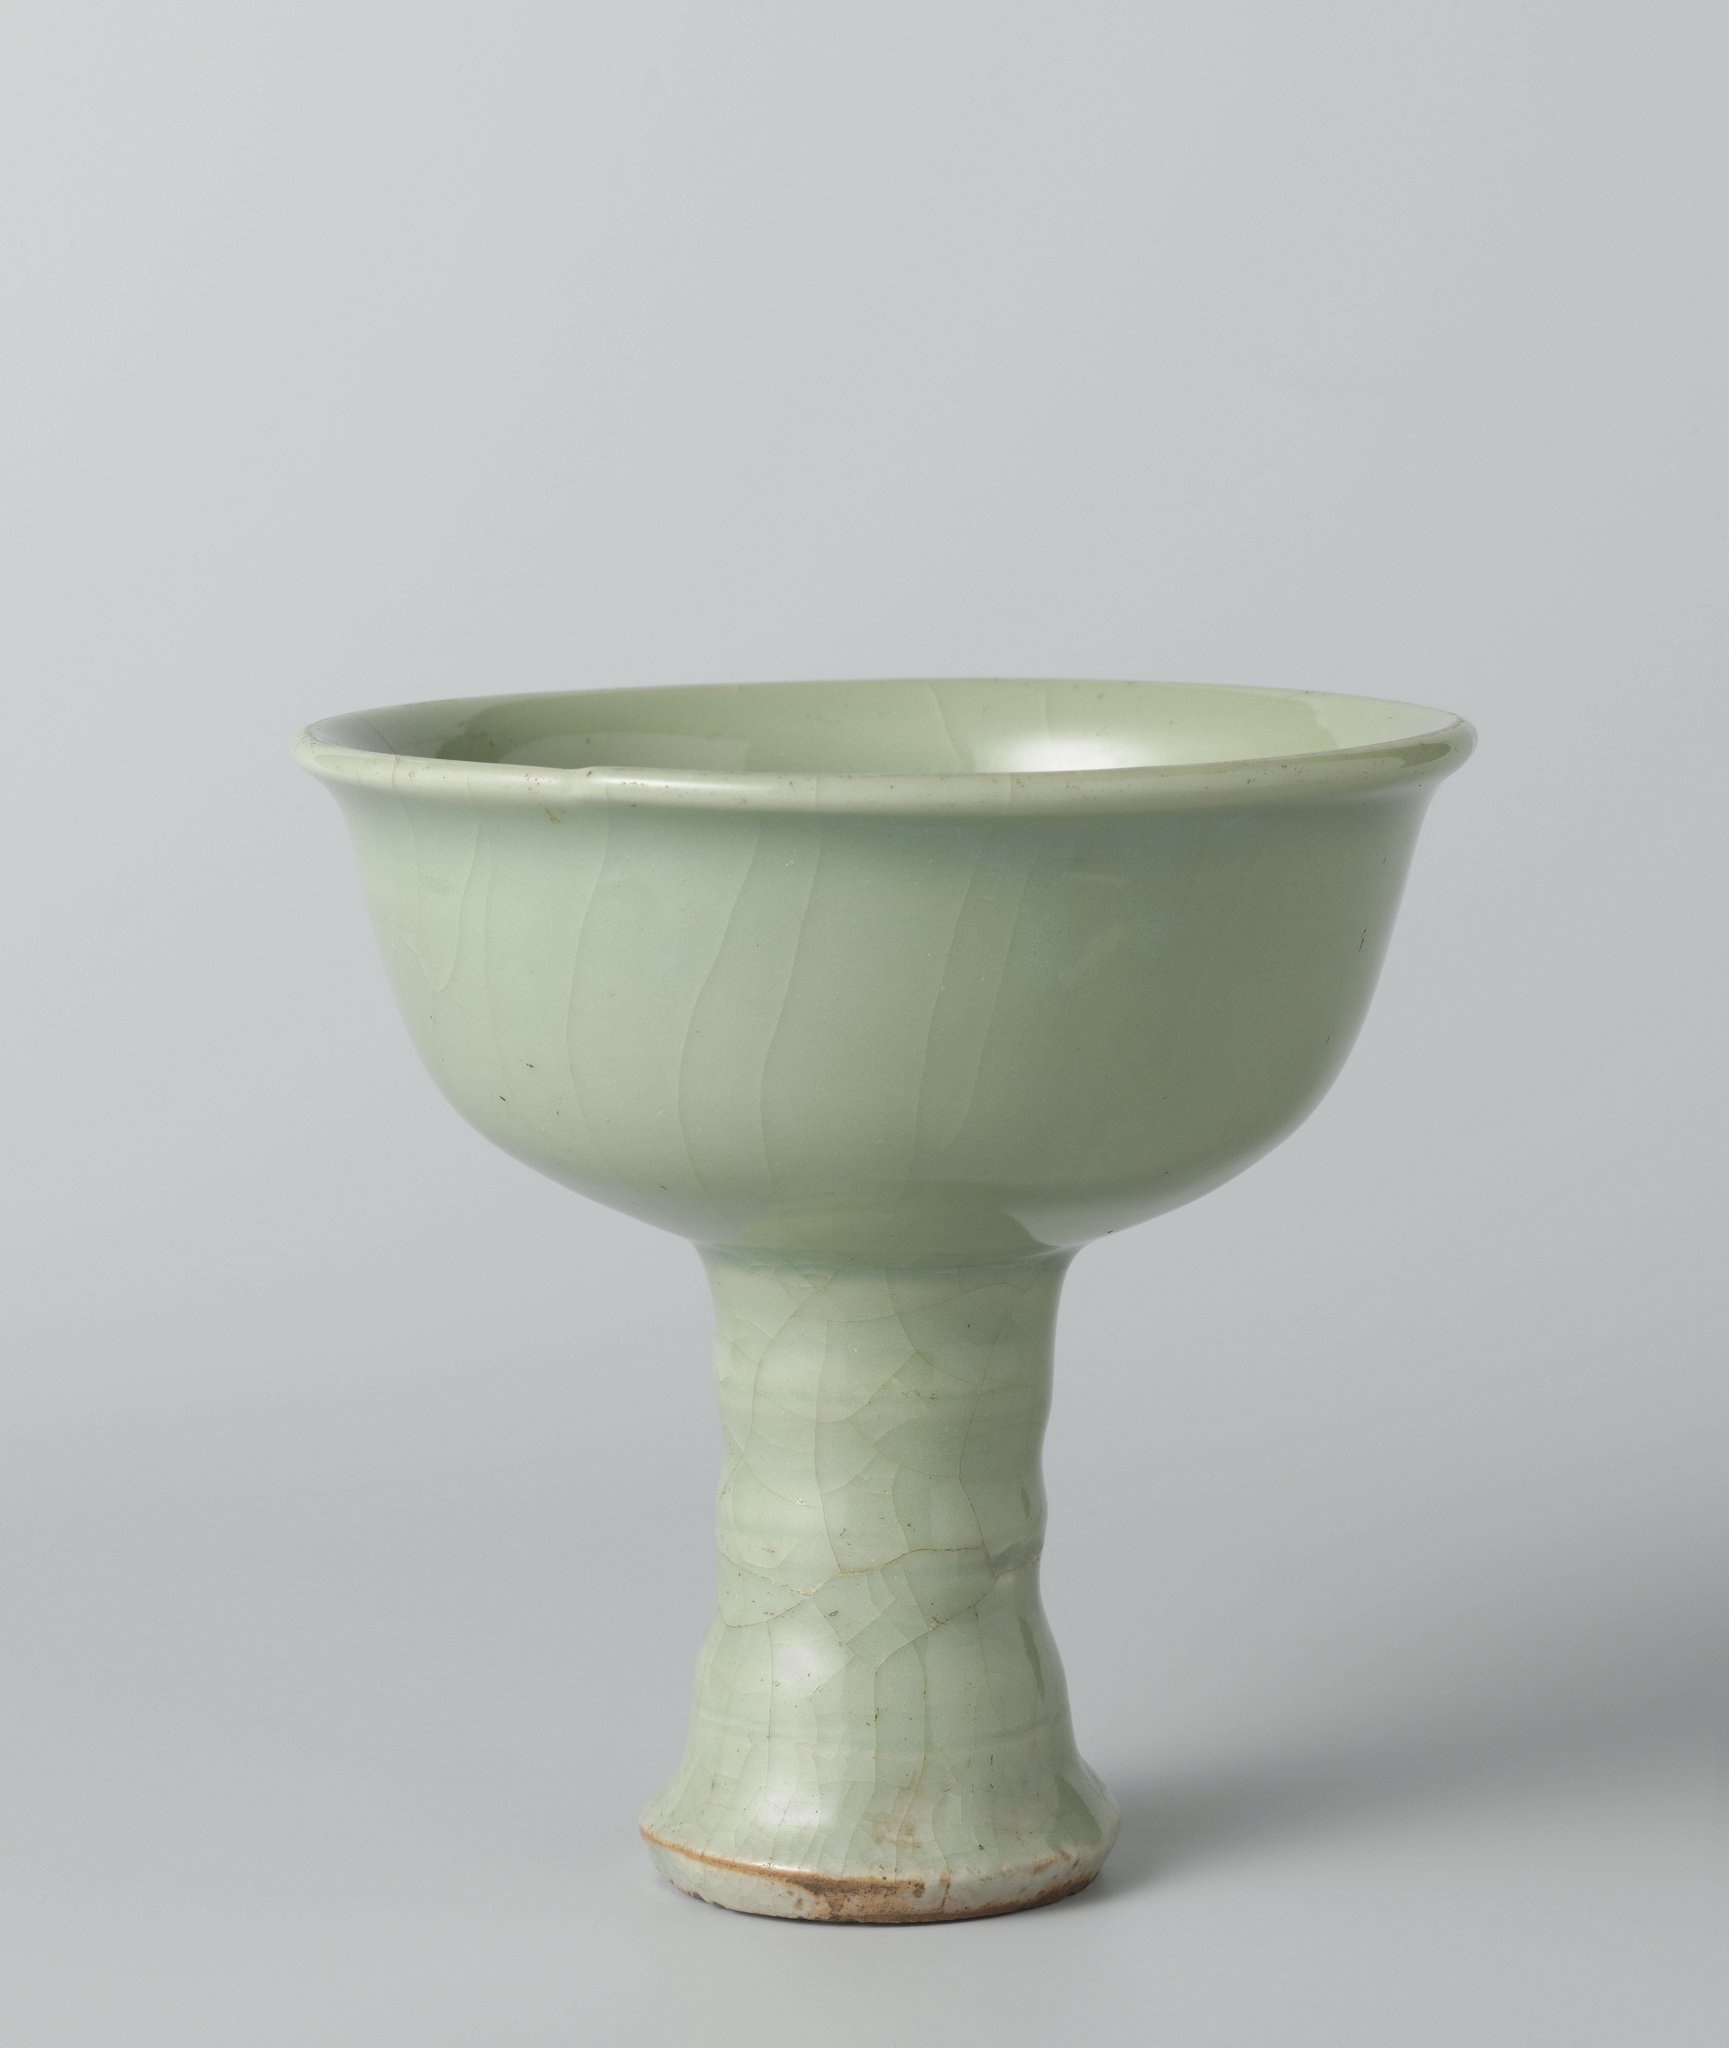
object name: standing bowl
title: Stemmed cup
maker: Anonymous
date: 1200-1399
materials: glaze, stoneware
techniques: firing, turning, vitrification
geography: china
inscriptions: label: ‘Bluett 1528’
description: Kom van steengoed met uitlopende rand op een hoge, naar beneden zich verbredende voet, bedekt met een vrij licht groen glazuur. Oud label op de onderzijde met 'Bluett 1528'. Celadon (Longquan).